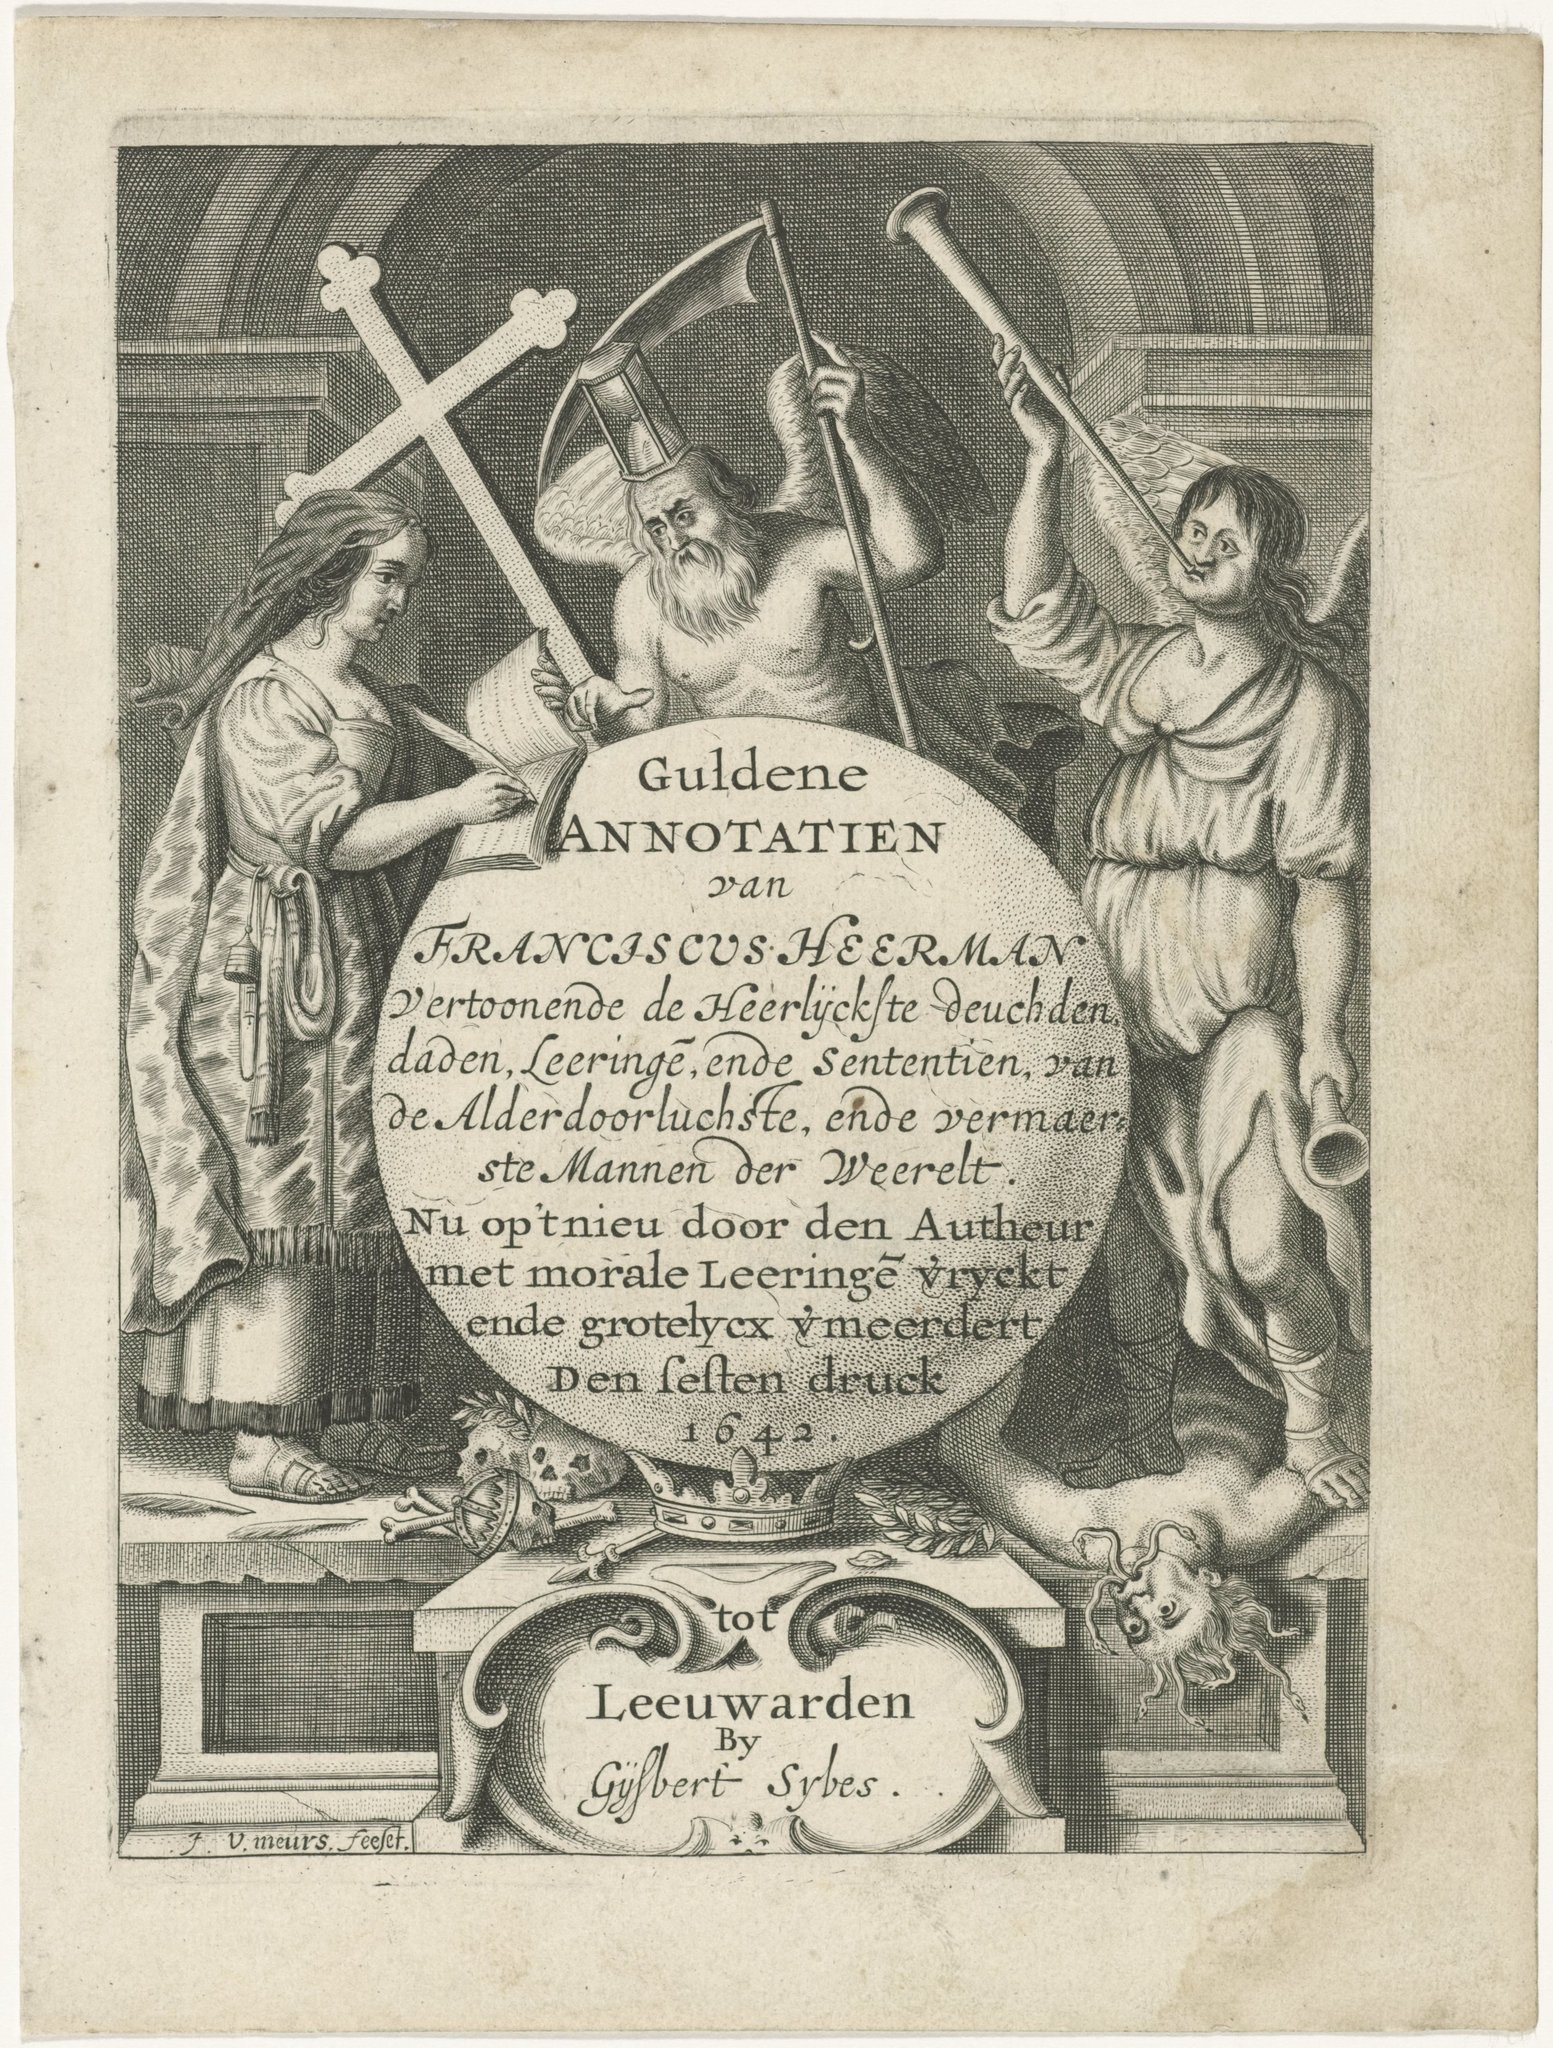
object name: titelblad, titelpagina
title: Geschiedenis, Vader Tijd en de Faam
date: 1642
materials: paper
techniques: engraving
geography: leeuwarden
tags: envy; 'invidia' (ripa) ~ personification of one of the seven deadly sins, 'historia'; 'historia' (ripa), fame; 'fama', 'fama buona', 'fama chiara' (ripa), father time, man with wings and scythe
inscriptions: collector's mark: Lugt 2228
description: Links Geschiedenis schrijft in een boek. Vader Tijd, met zeis en zandloper, wijst op de titel. Rechts Faam, staande op de Afgunst. Titelpagina voor een boek over beroemde mensen.